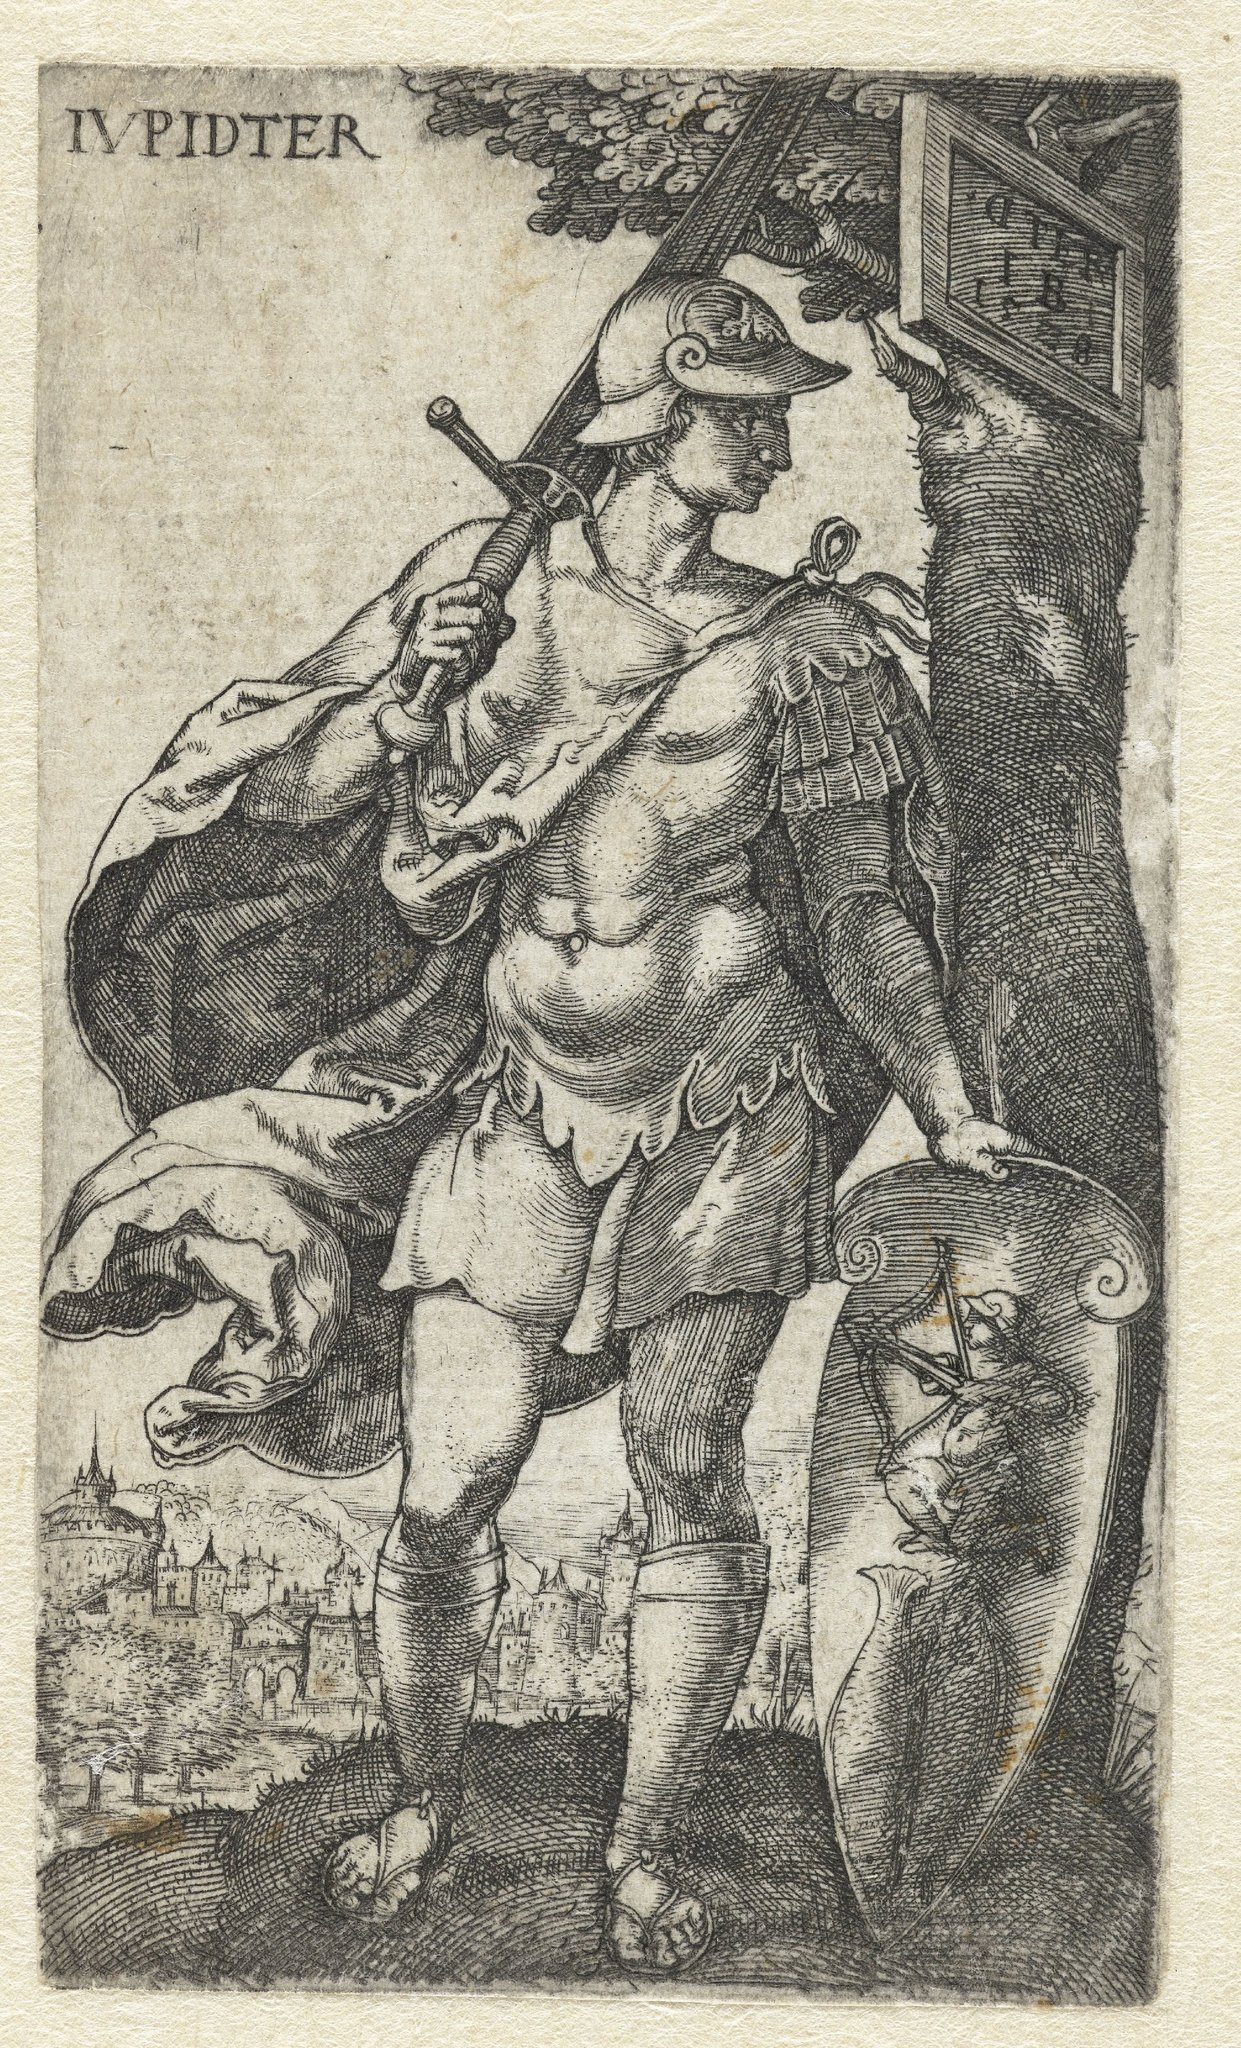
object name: print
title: Ivpidter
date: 1528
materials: paper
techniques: engraving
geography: germany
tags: (story of) jupiter (zeus)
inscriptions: collector's mark: ‘Hinloopen’ Lugt 11, collector's mark: Lugt 2228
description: Jupiter met wapenuitrusting staand naast een boom, op zijn schild de sterrenbeelden Boogschutter en Vissen.